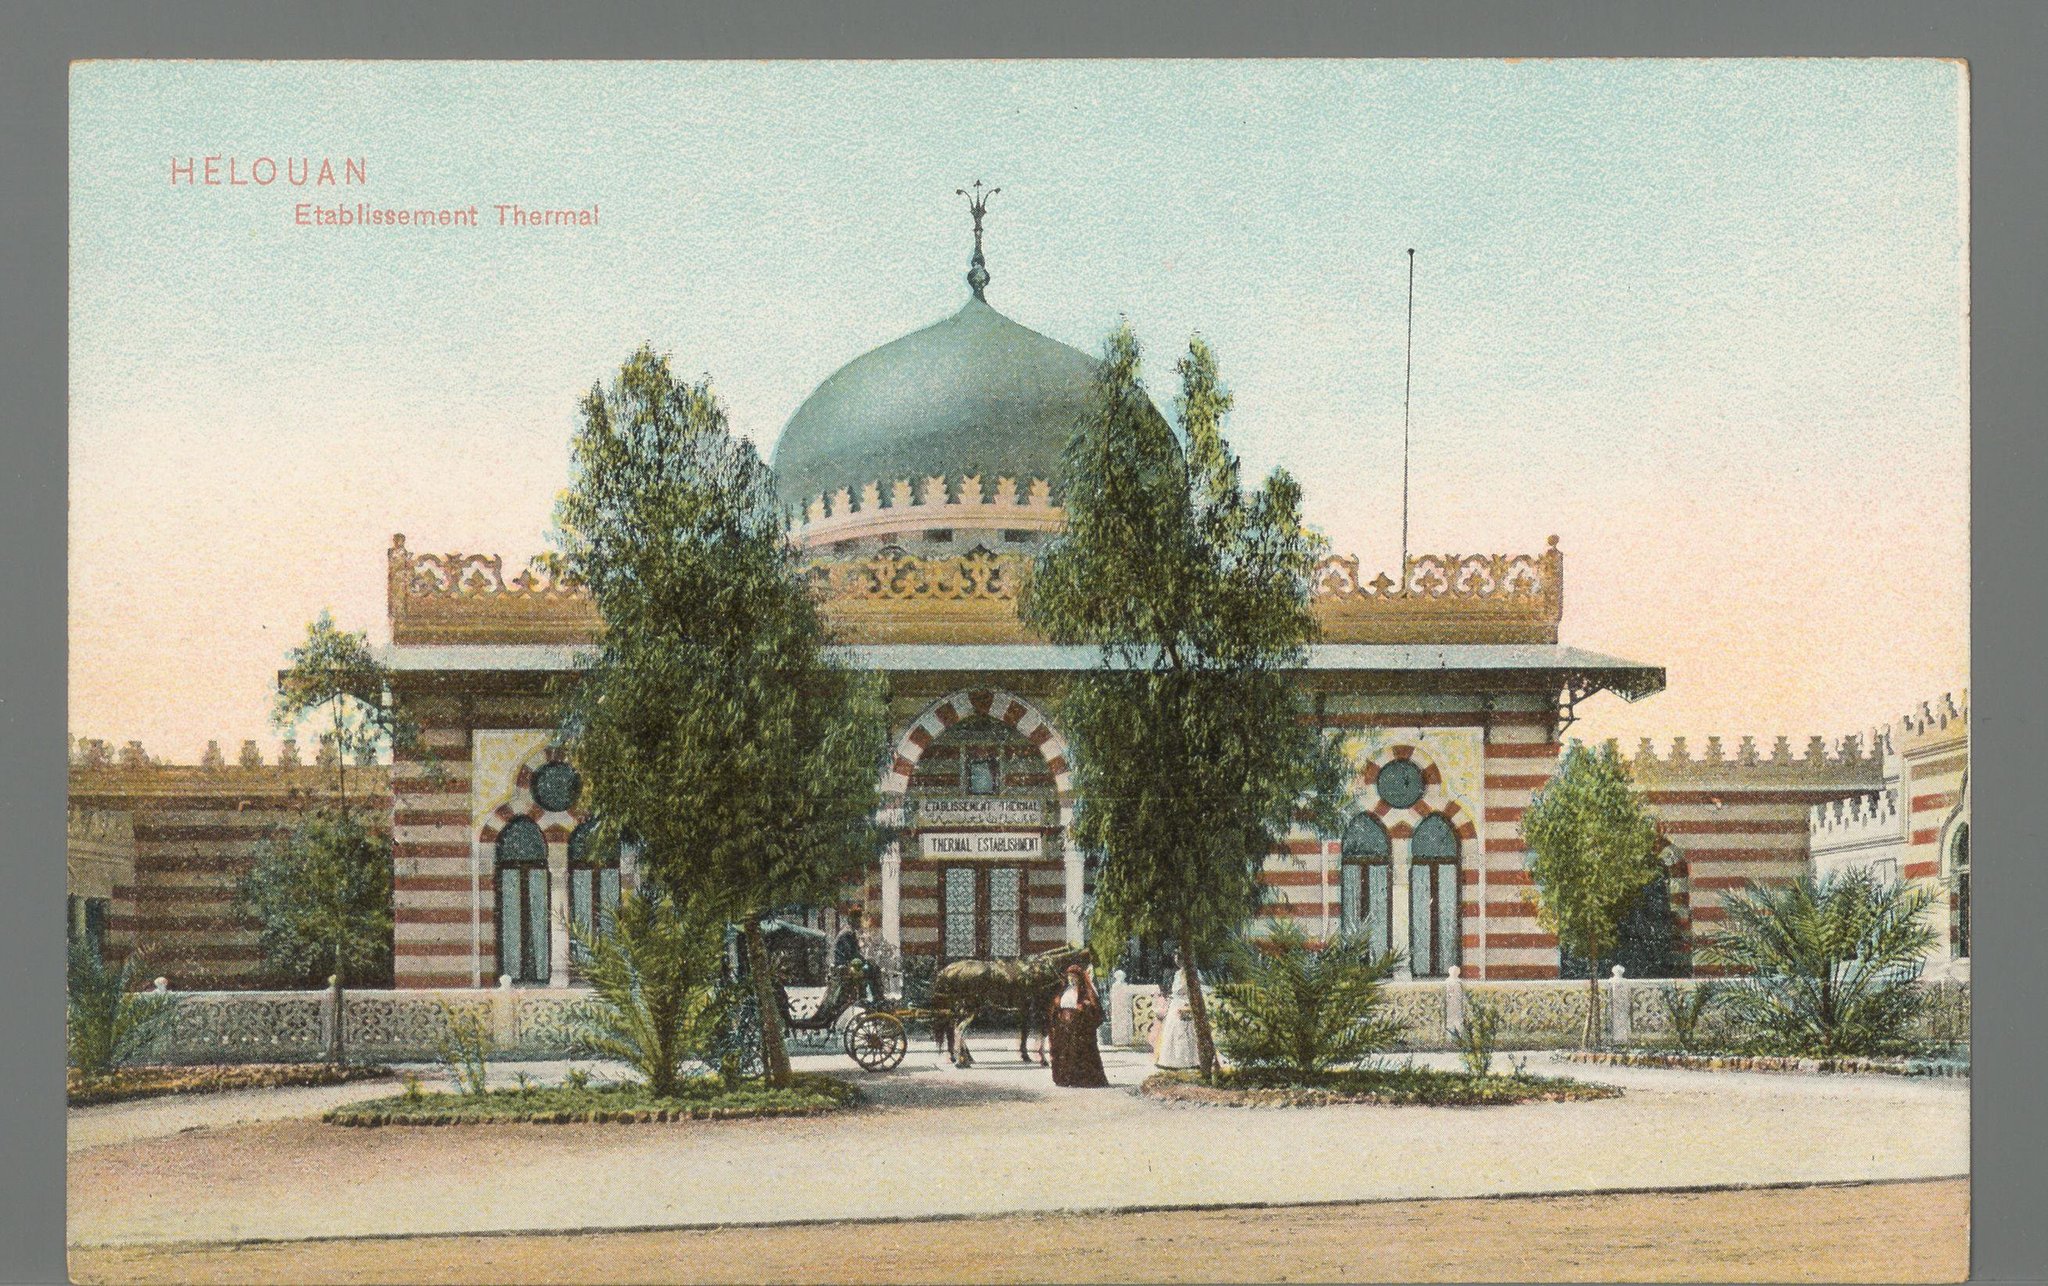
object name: ansichtkaart, prentbriefkaart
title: Helouan. Etablissement Thermal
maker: Anonymous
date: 1907-1930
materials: cardboard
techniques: lithograph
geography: hulwan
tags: watering-place, spa